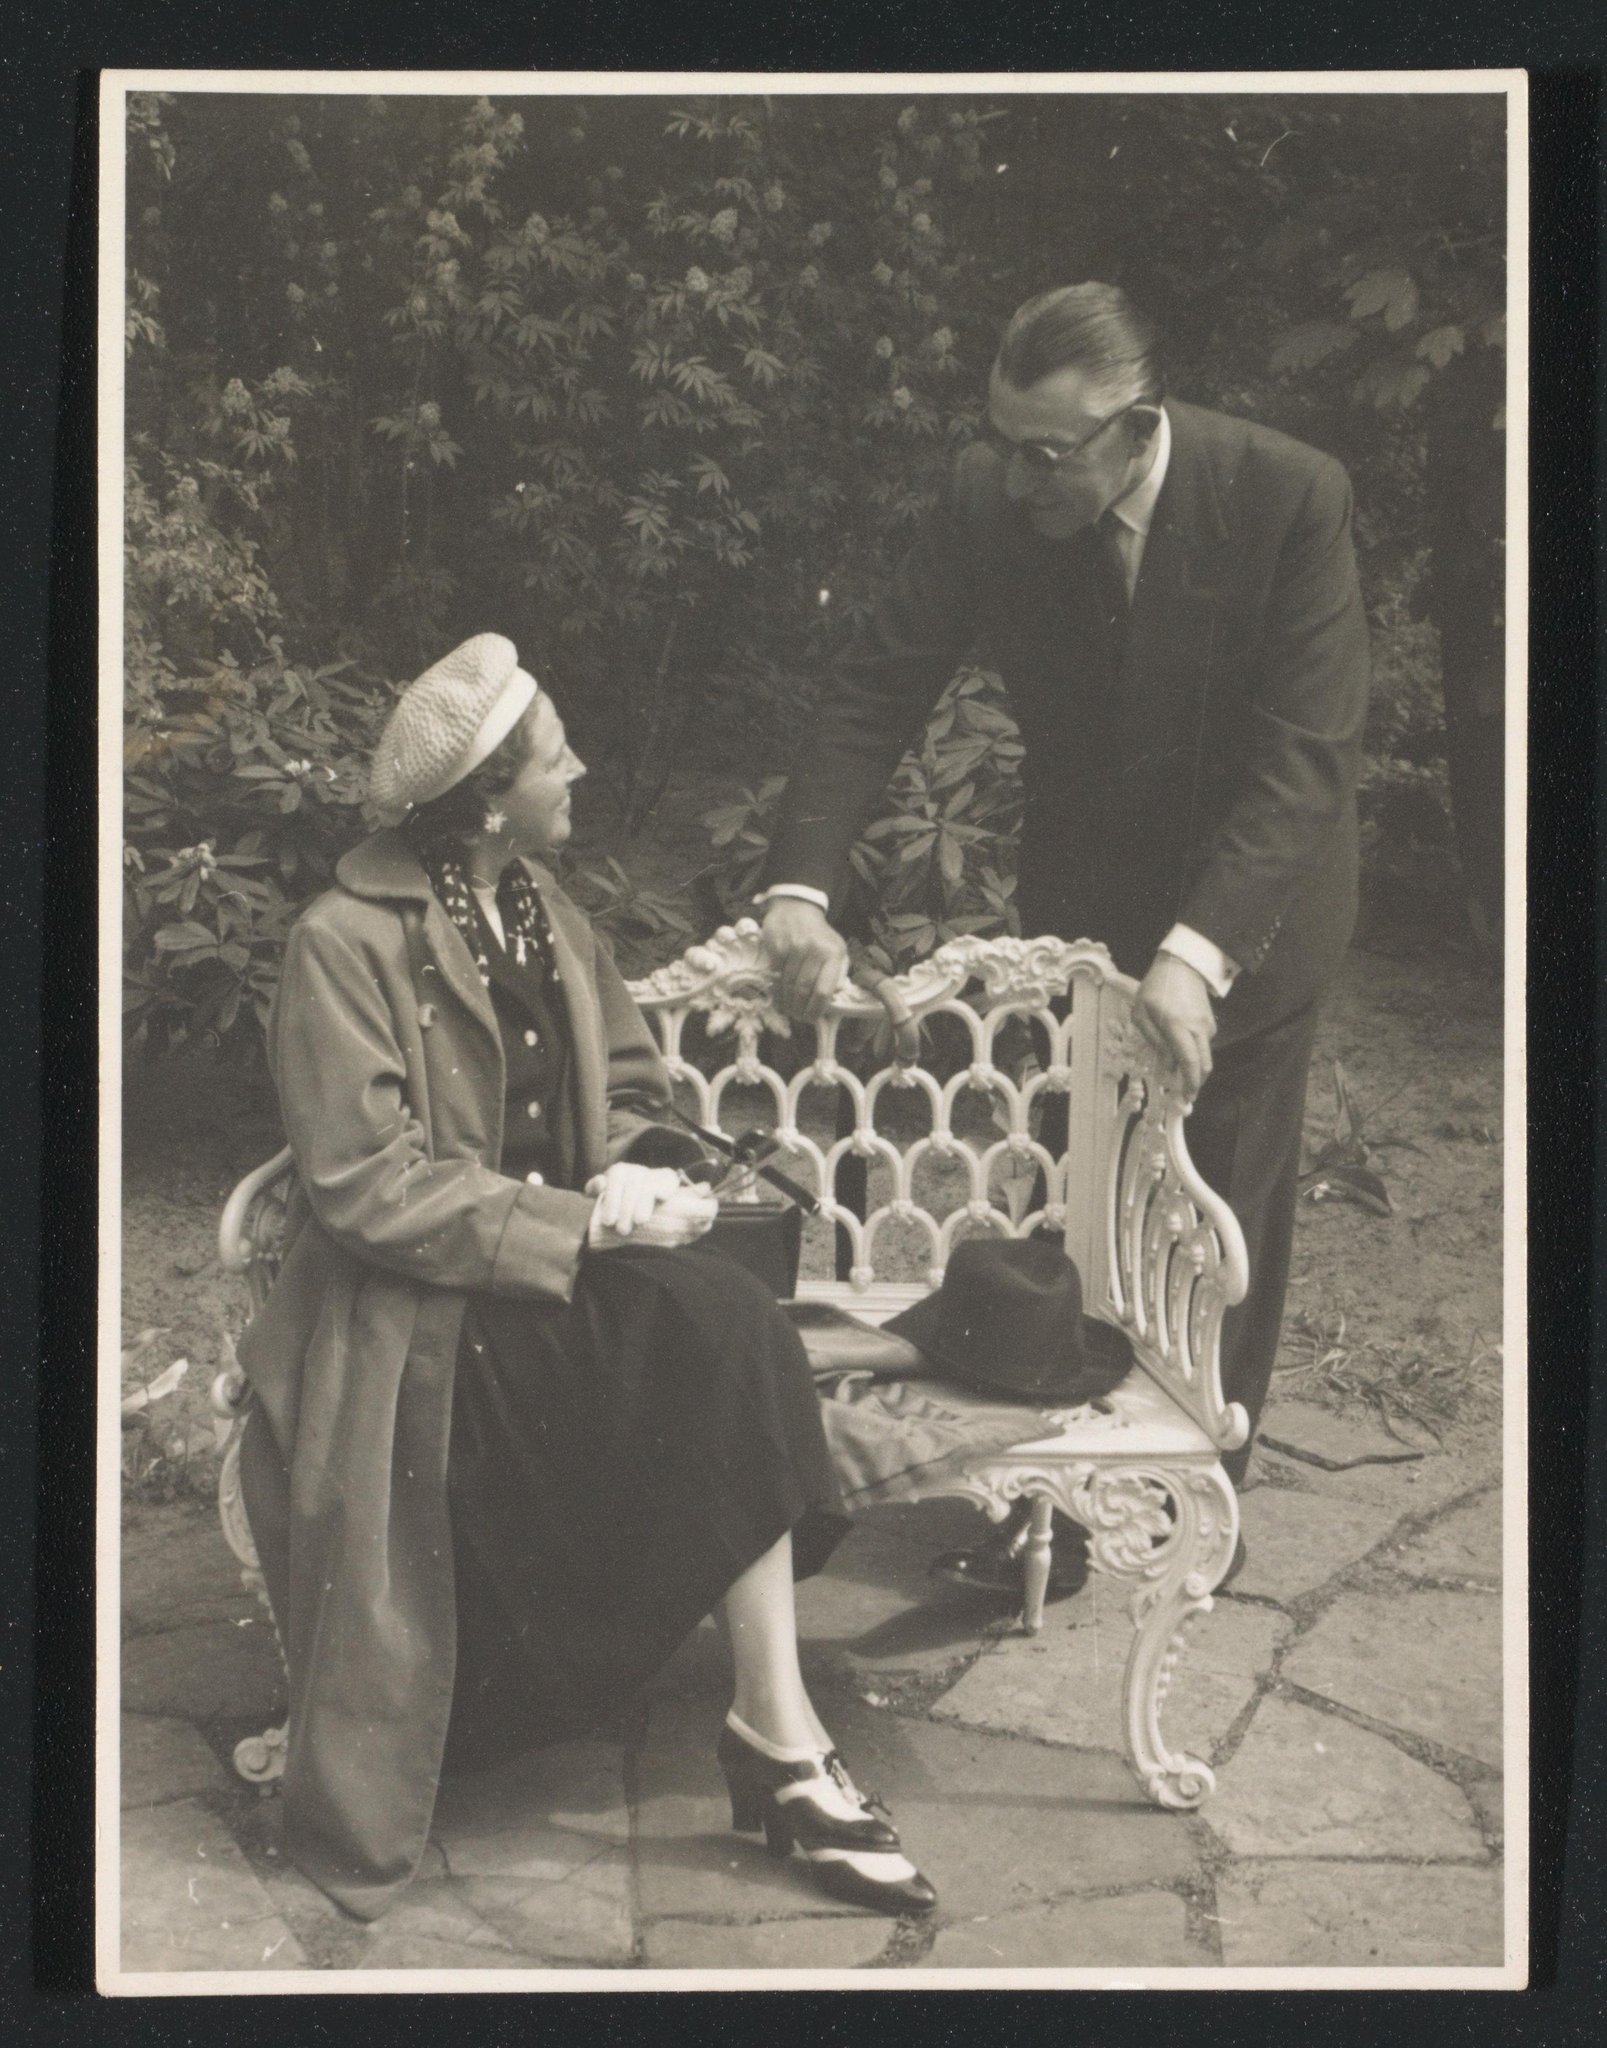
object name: photograph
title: G.A. Brusse-Urtebise zittend op een gietijzeren tuinbank in gezelschap van een man in de Keukenhof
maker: Anonymous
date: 1957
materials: photographic support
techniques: gelatin silver print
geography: keukenhof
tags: amsterdam, garden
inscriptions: inscription: ‘1957? Madame! Visite des Danois Keukenhof’